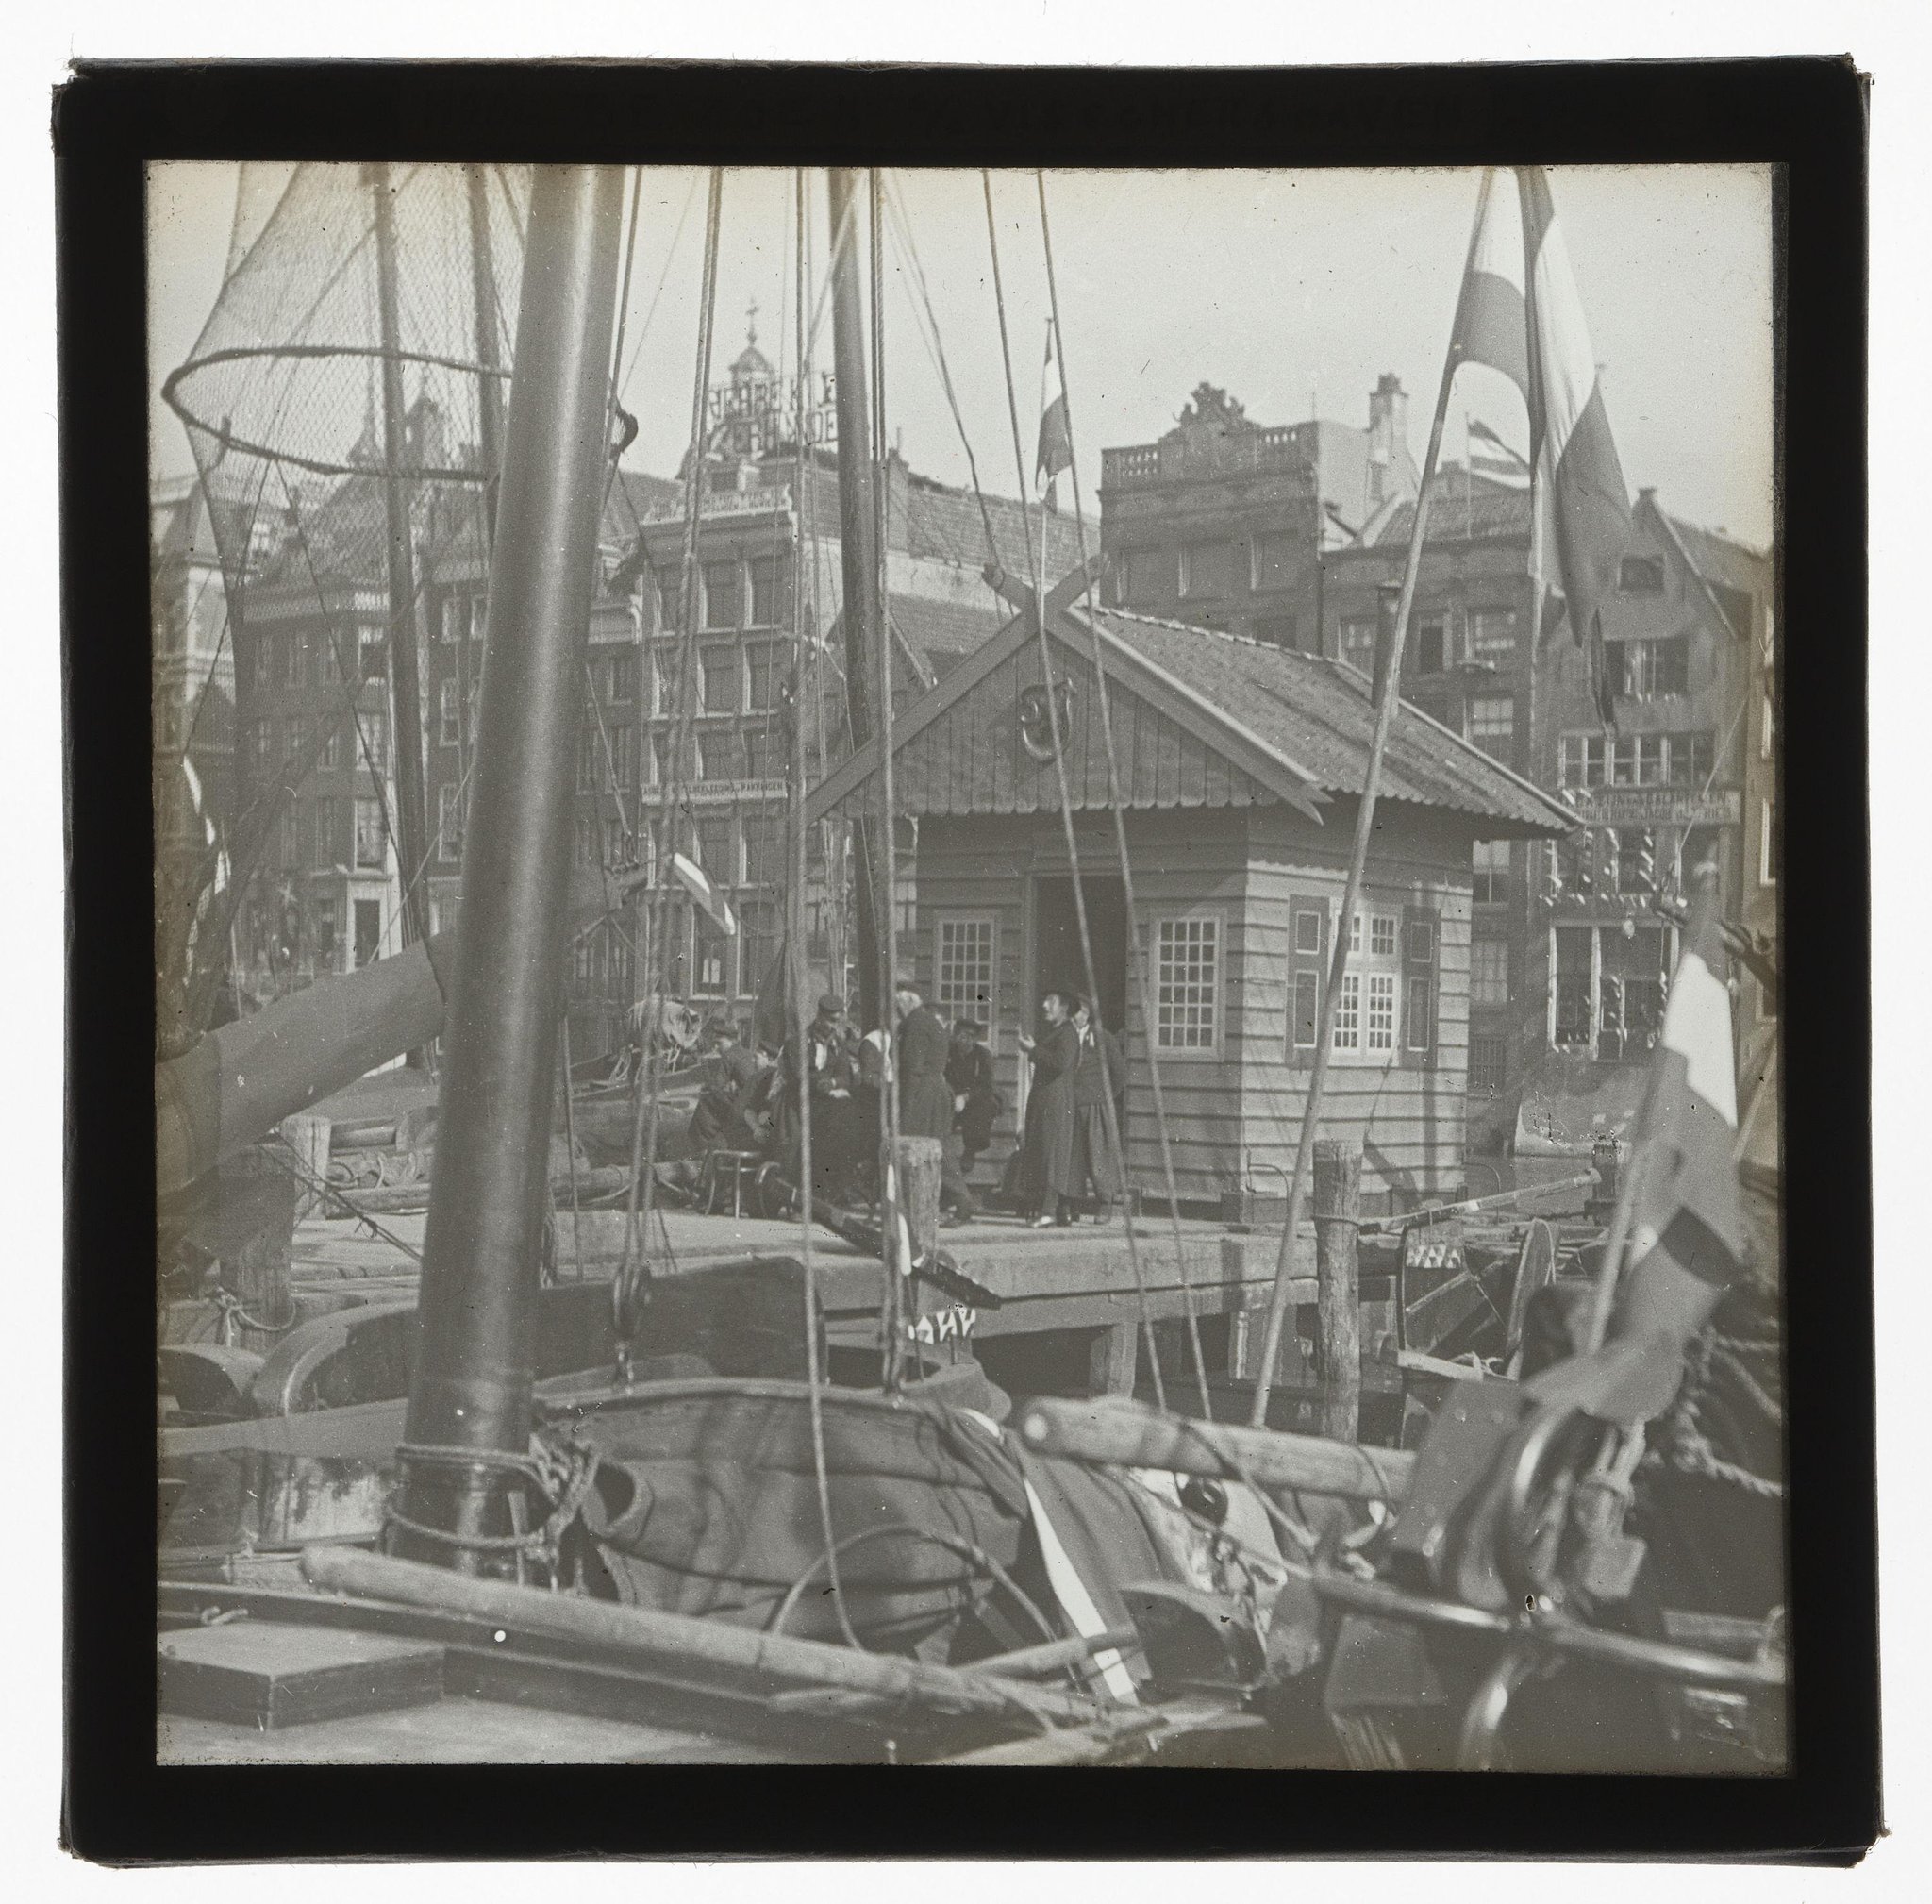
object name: lantern slide photographic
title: Gezelschap in een vissershaven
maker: machiel gerrit george suyver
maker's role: fotograaf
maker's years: 1872-1933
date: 1898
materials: glass, paper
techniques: gelatin silver transparency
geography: netherlands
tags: the hague, print maker, wilhelmina of the netherlands, harbour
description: Damrak te Amsterdam met versierde vissersschepen ter gelegenheid van de inhuldiging van koningin Wilhelmina.